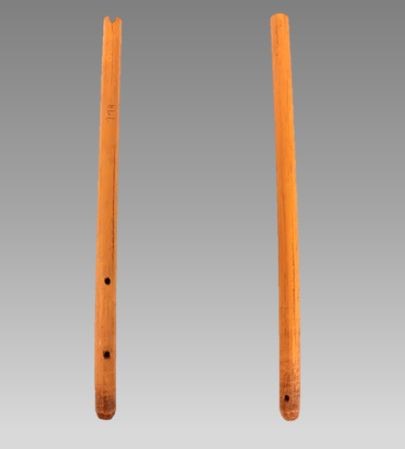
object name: mai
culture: melanesian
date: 1867-1900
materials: bamboo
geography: vanuatu